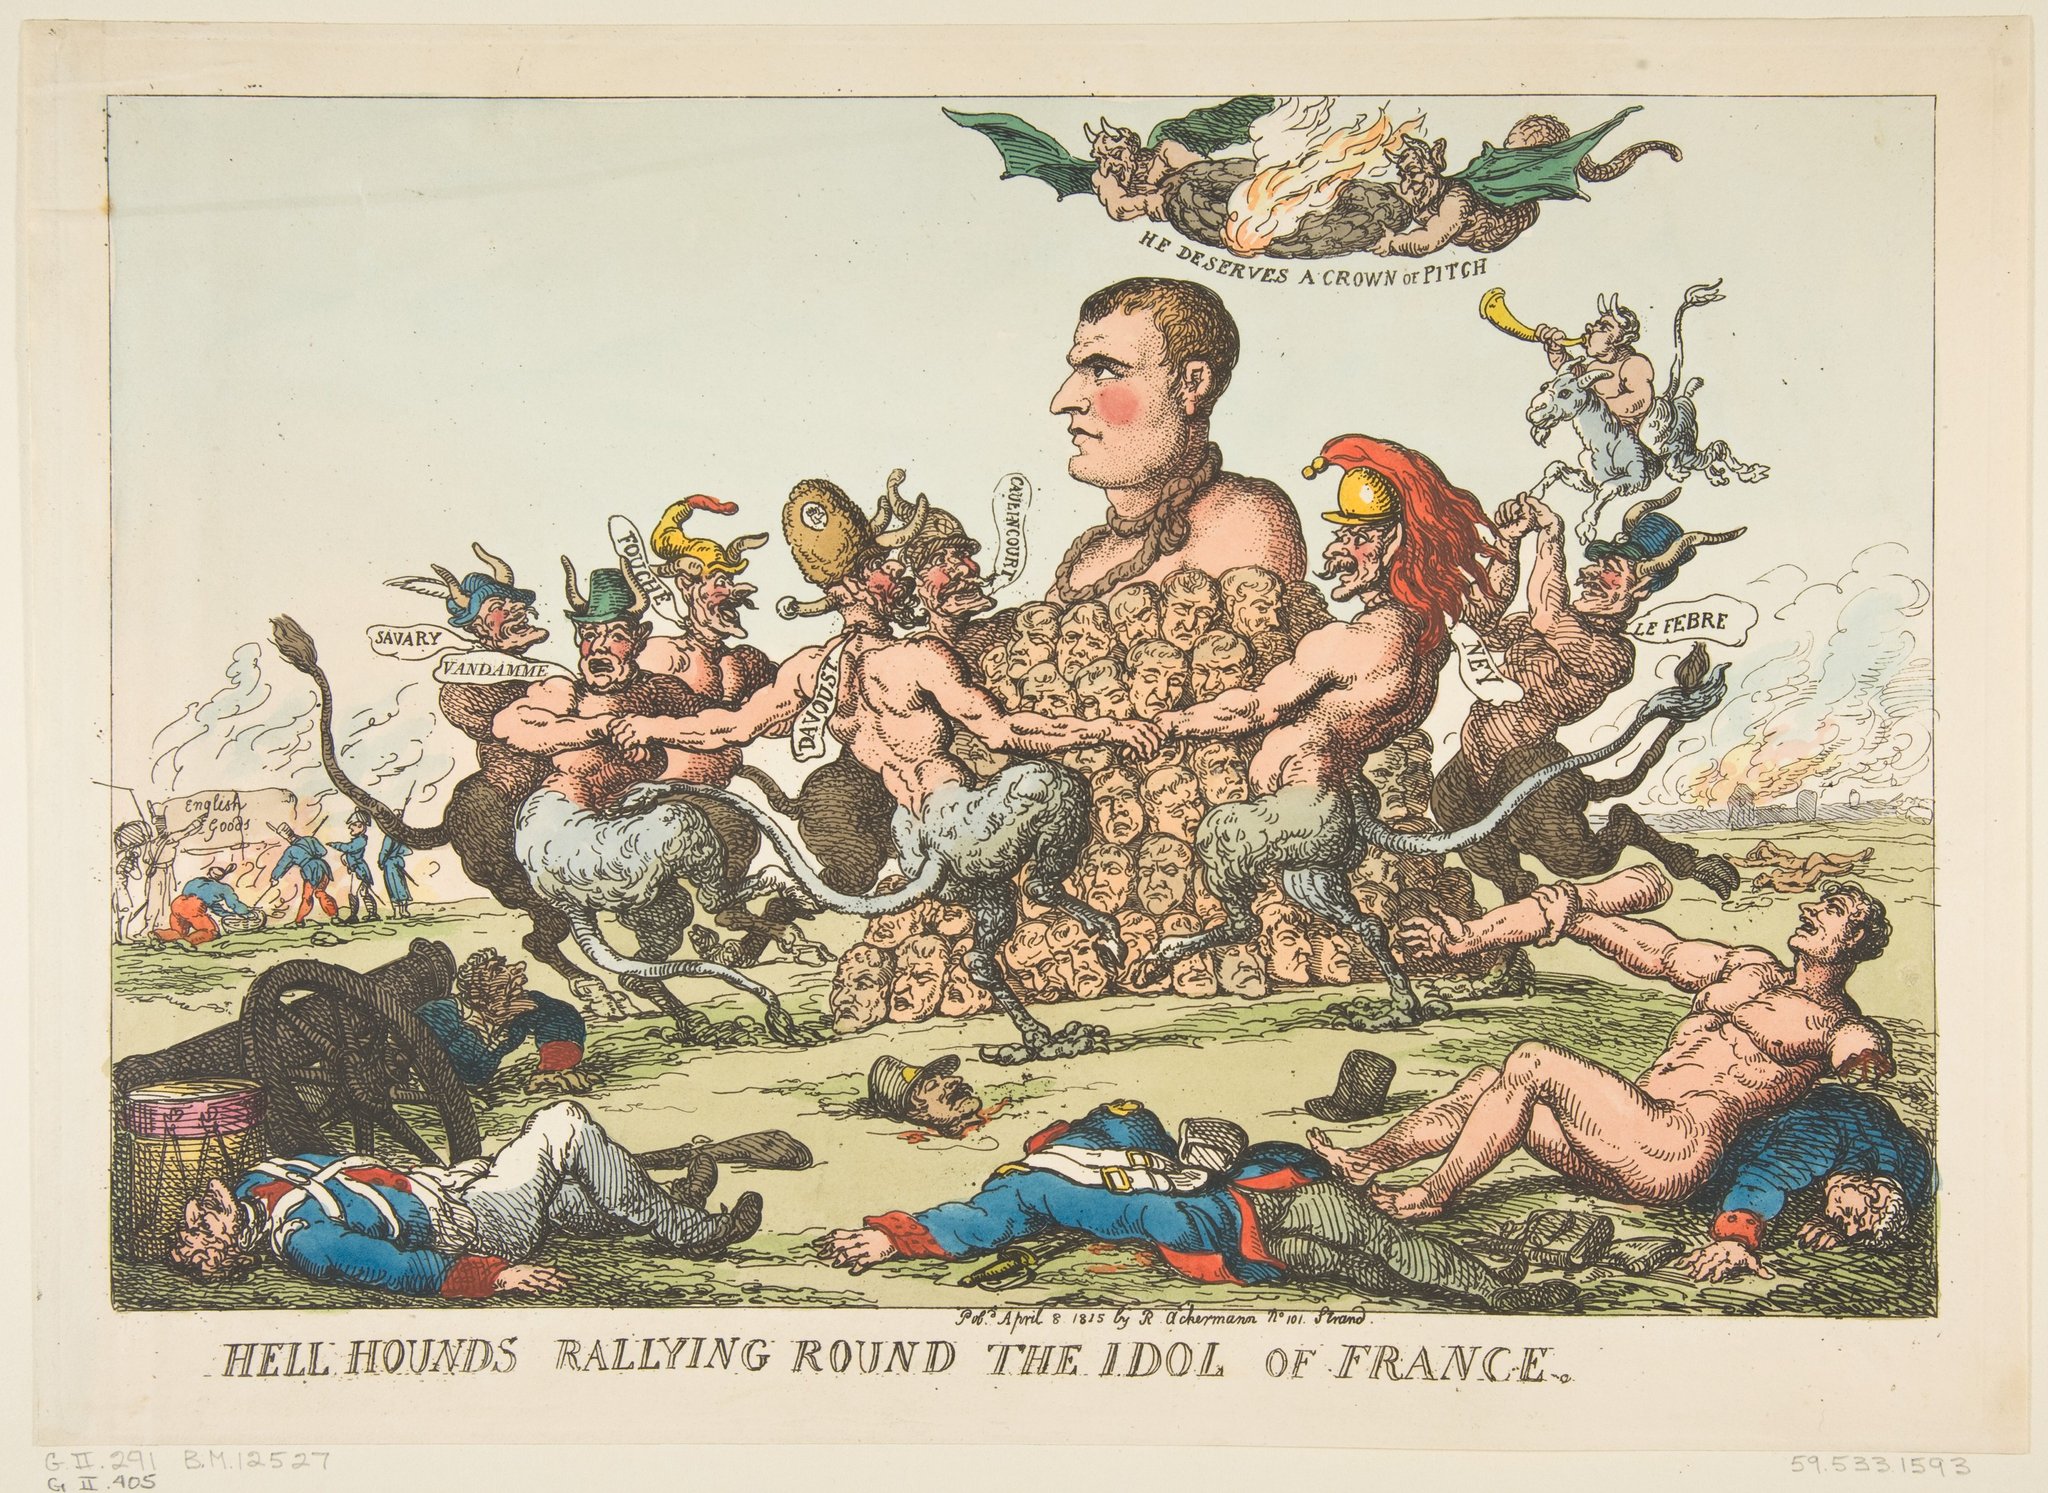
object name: print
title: Hell Hounds Rallying Round the Idol of France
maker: thomas rowlandson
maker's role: artist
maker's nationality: british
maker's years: 1757-1827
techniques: etching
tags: satire,napoleon i,politics